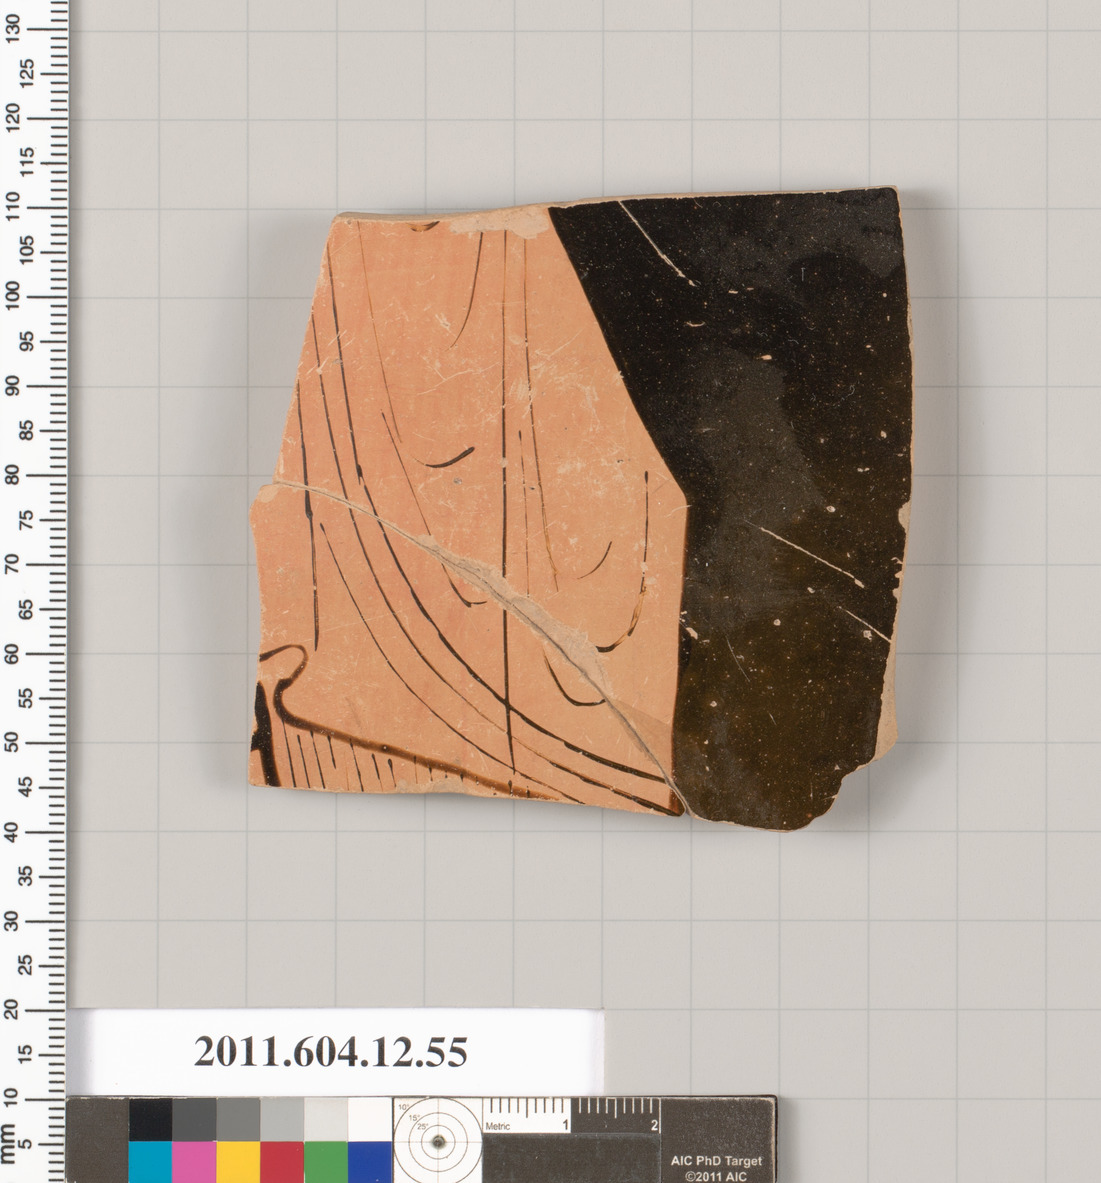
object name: krater fragment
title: Terracotta fragment of krater (deep bowl)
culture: greek or south italian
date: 400-301 BCE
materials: terracotta